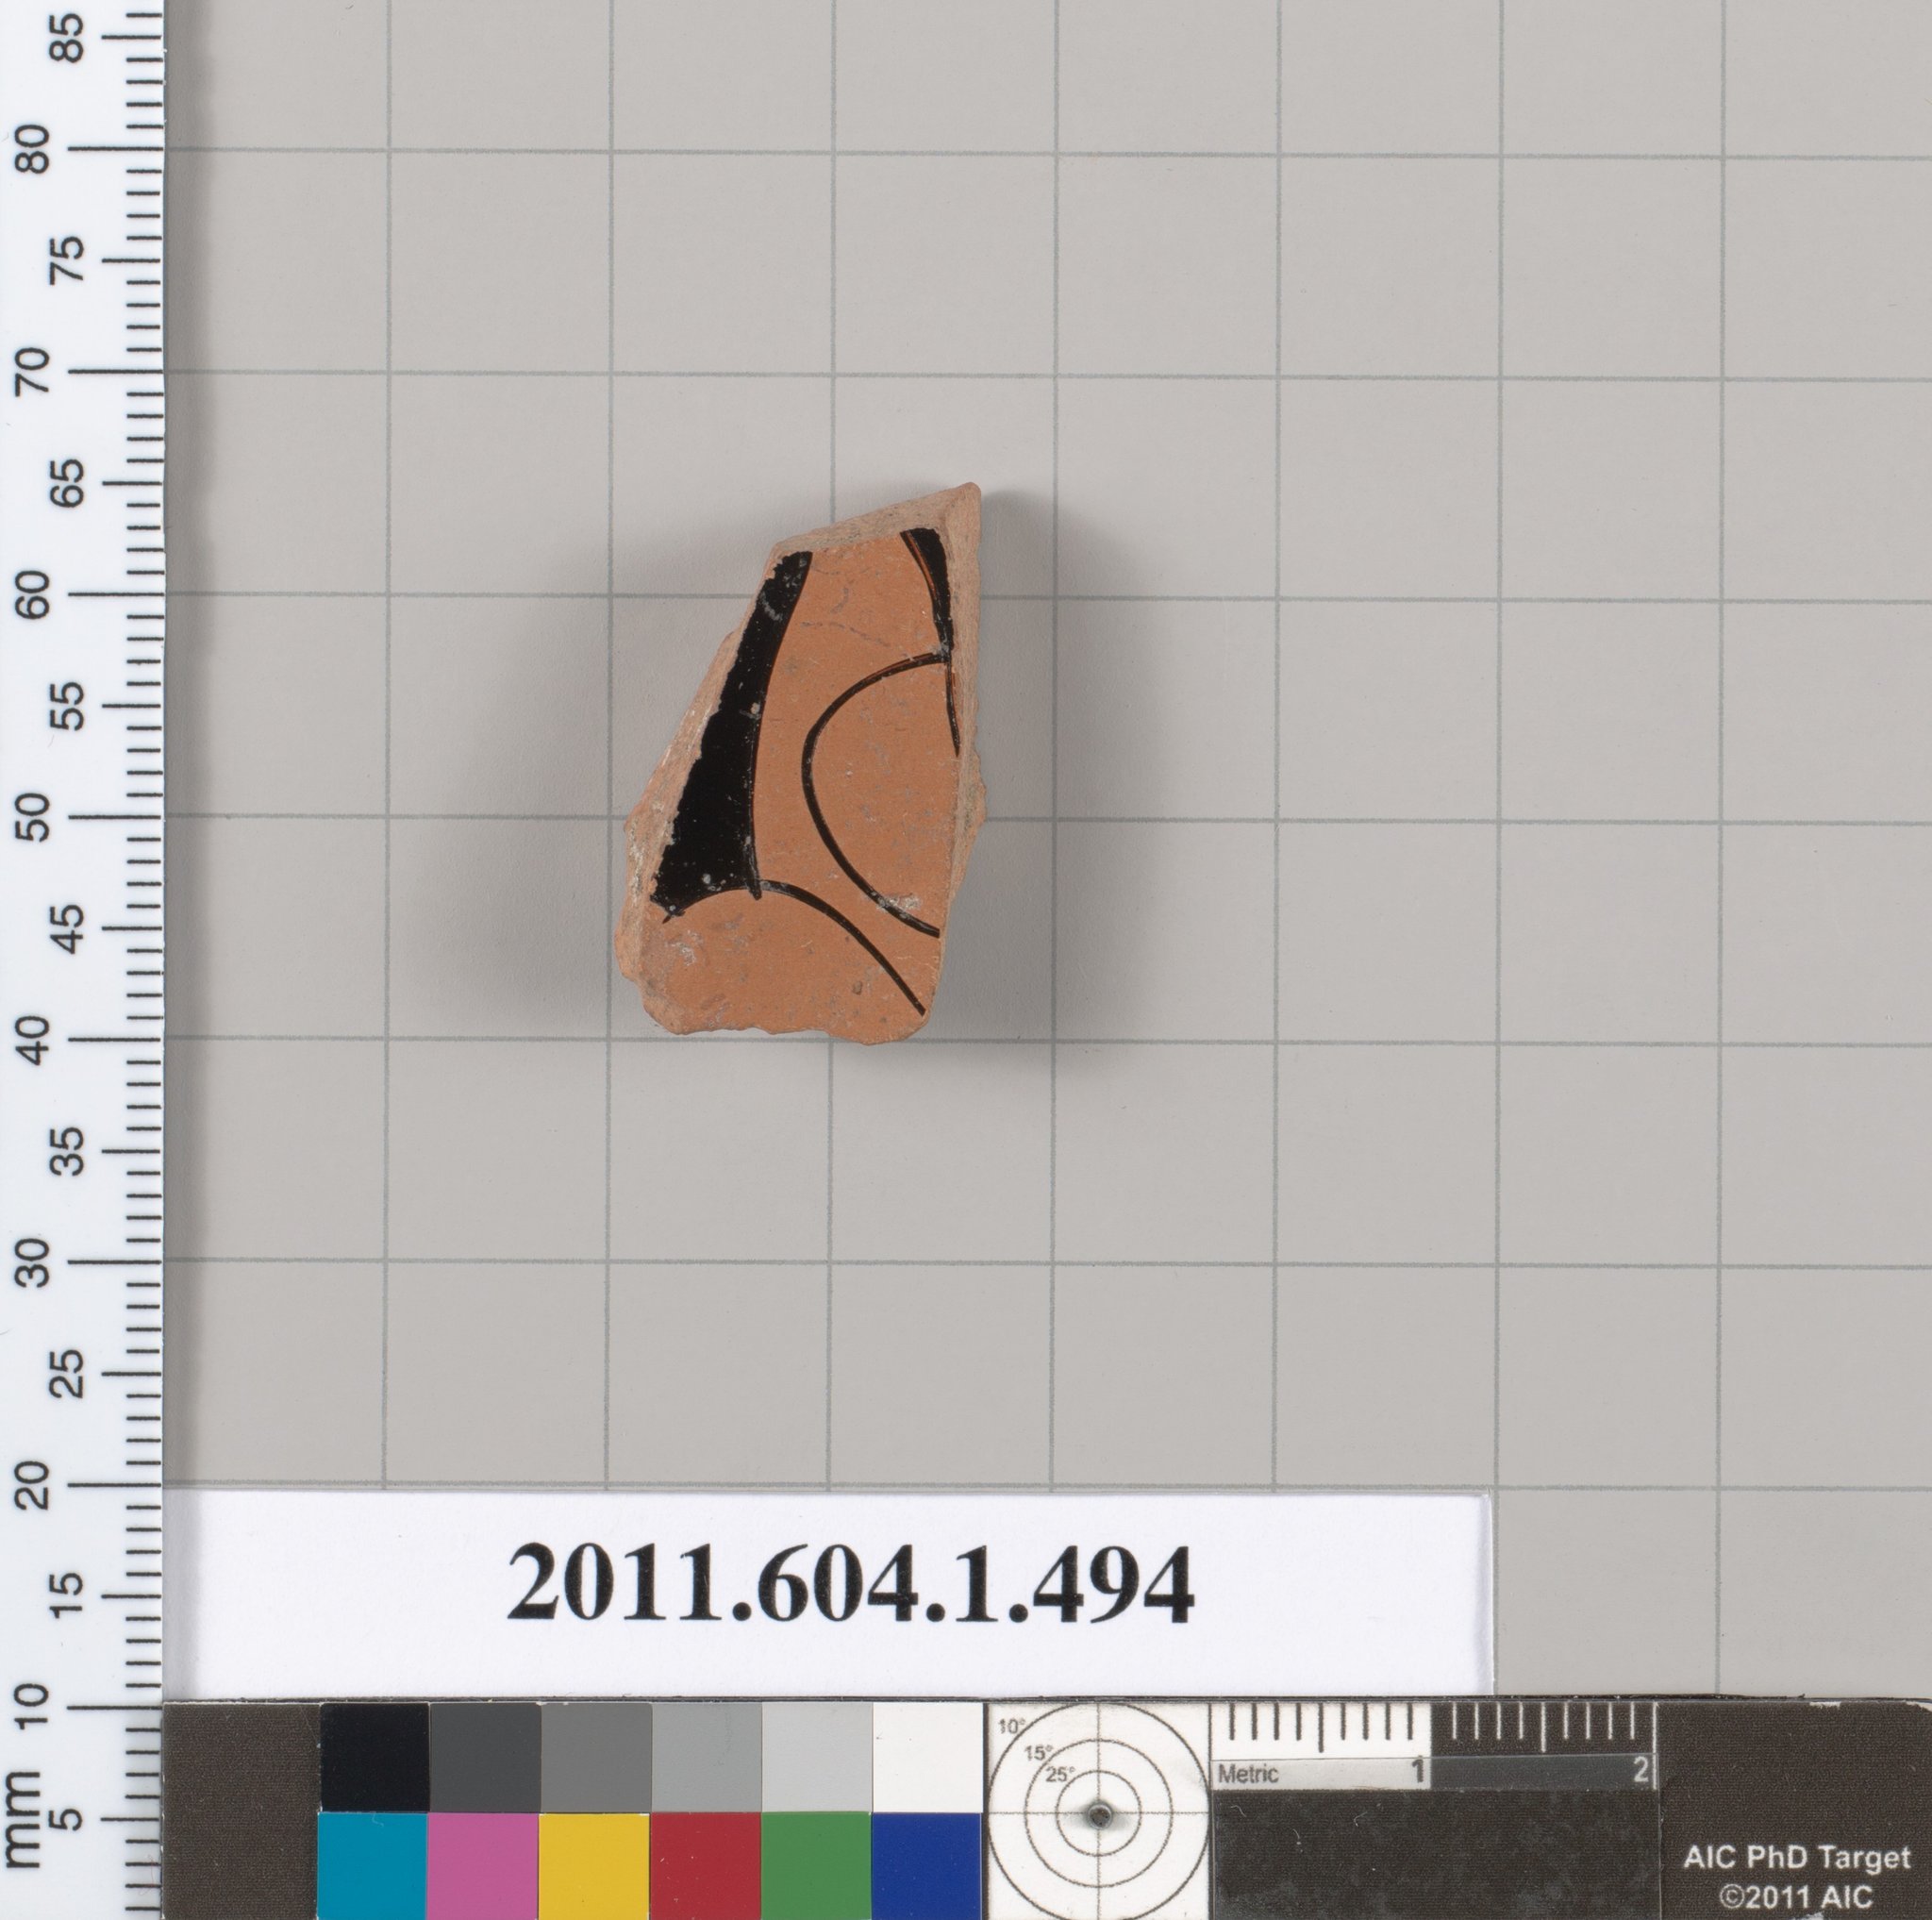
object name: kylix fragment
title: Terracotta fragment of a kylix (drinking cup)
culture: greek, attic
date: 490-480 BCE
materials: terracotta